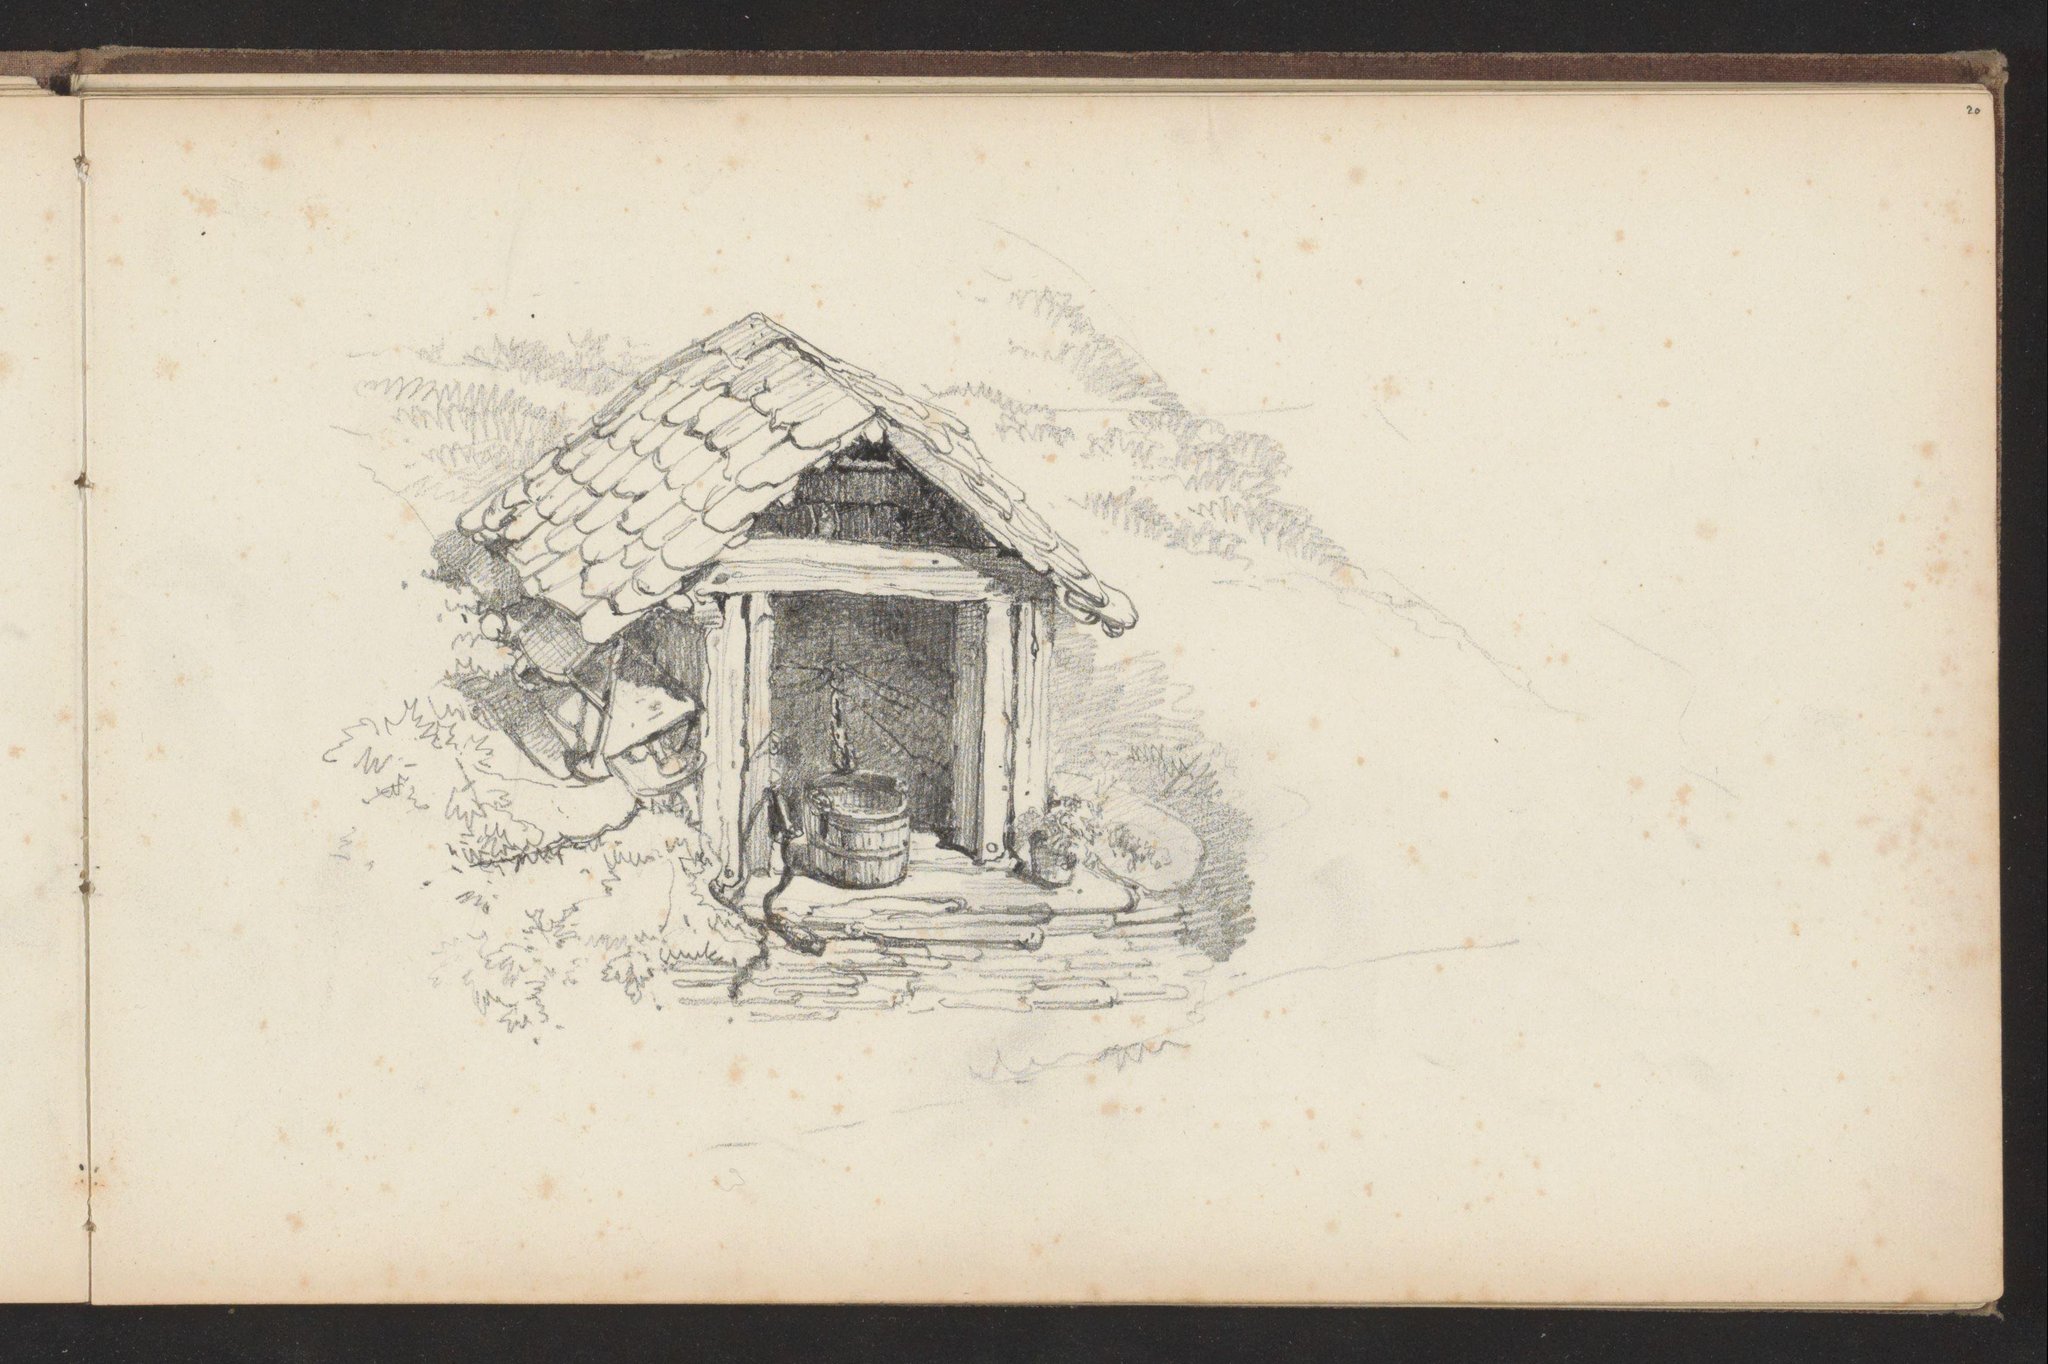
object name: sketchbook leaf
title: Waterput met een afdak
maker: maria vos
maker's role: draughtsman, painter, print maker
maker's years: 1824-1906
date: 1860-1865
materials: paper, pencil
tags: well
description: Blad 20 recto uit een schetsboek met 55 bladen.